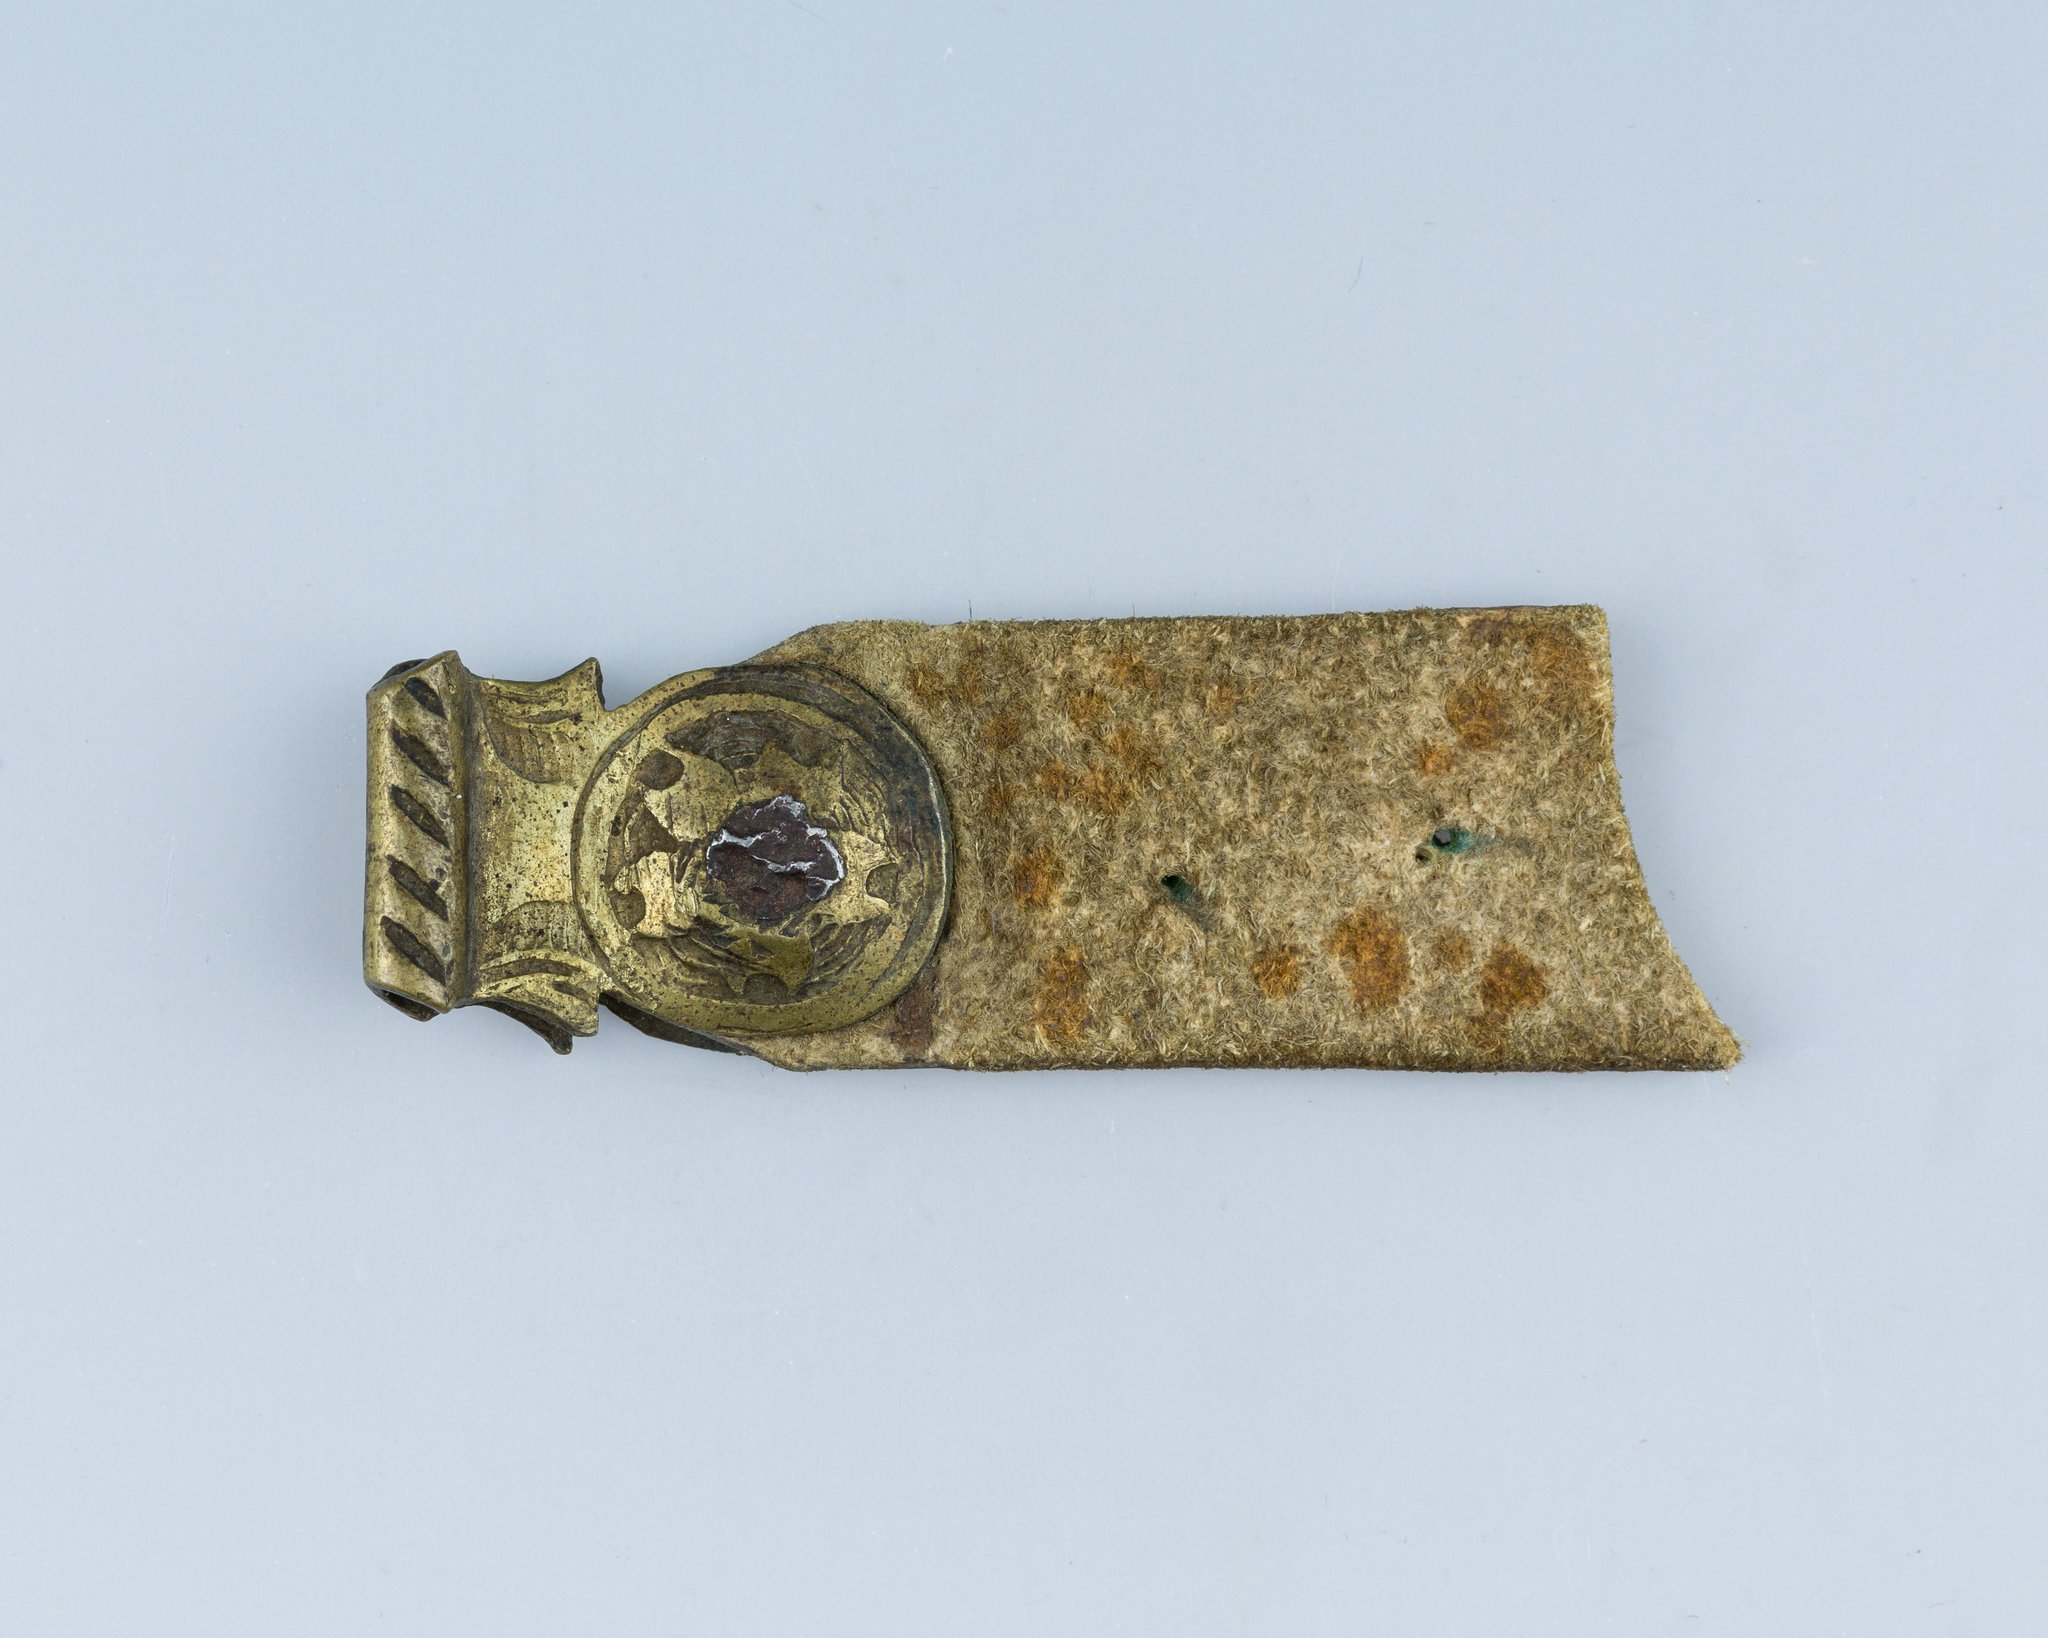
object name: mordant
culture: german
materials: brass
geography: germany